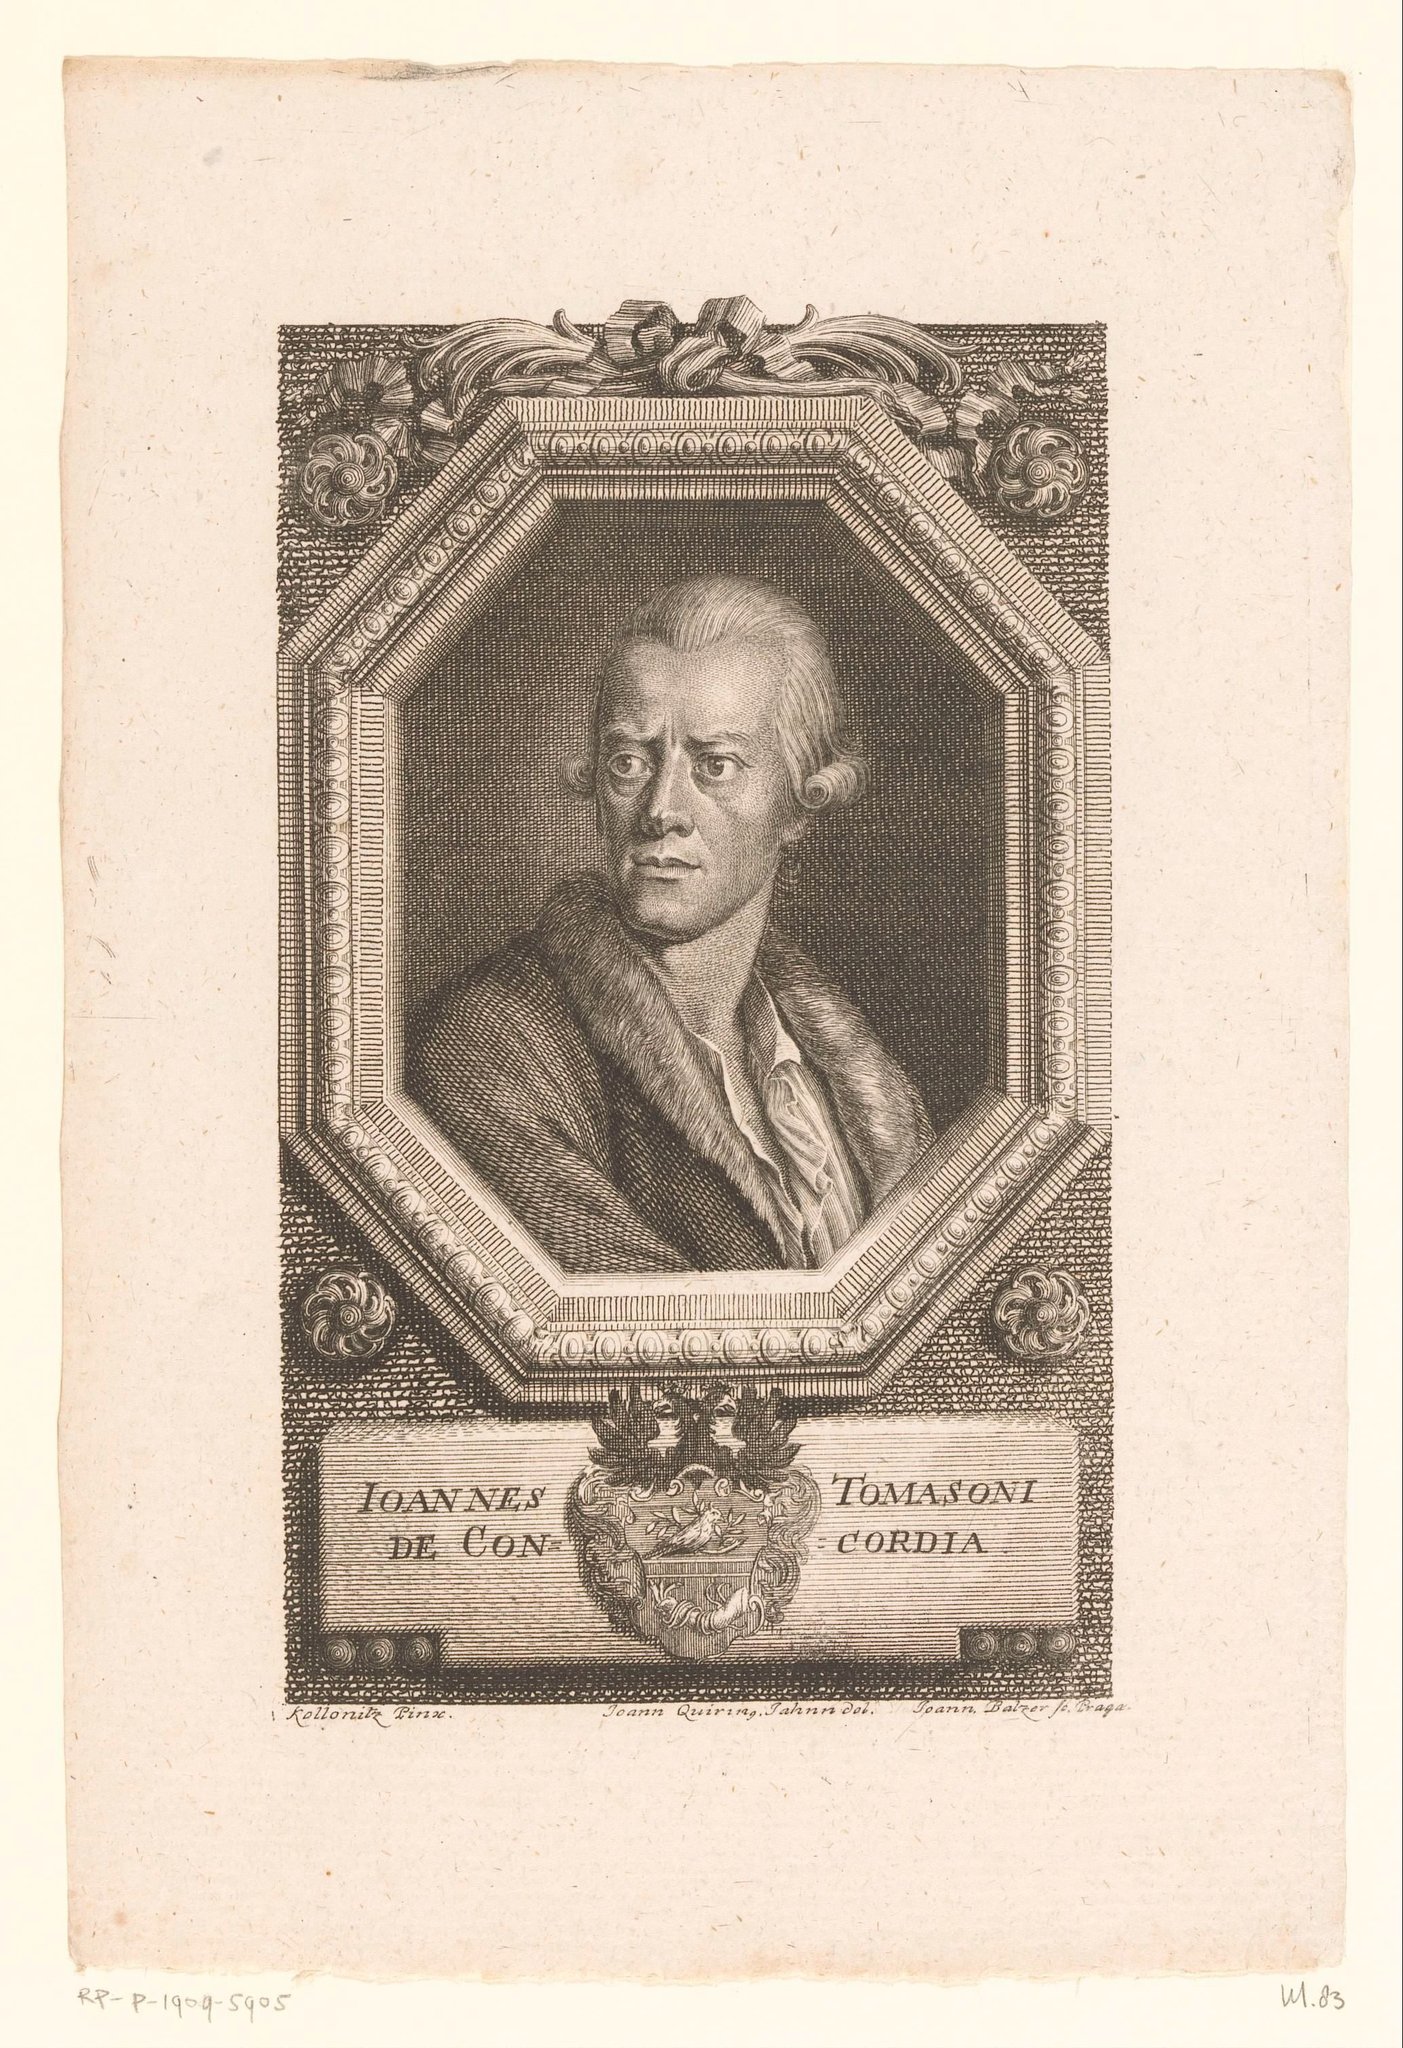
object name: print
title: Ioannes Tomasoni de Concordia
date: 1749-1799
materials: paper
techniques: engraving, etching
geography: prague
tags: vienna, historical persons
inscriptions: collector's mark: Lugt 2228